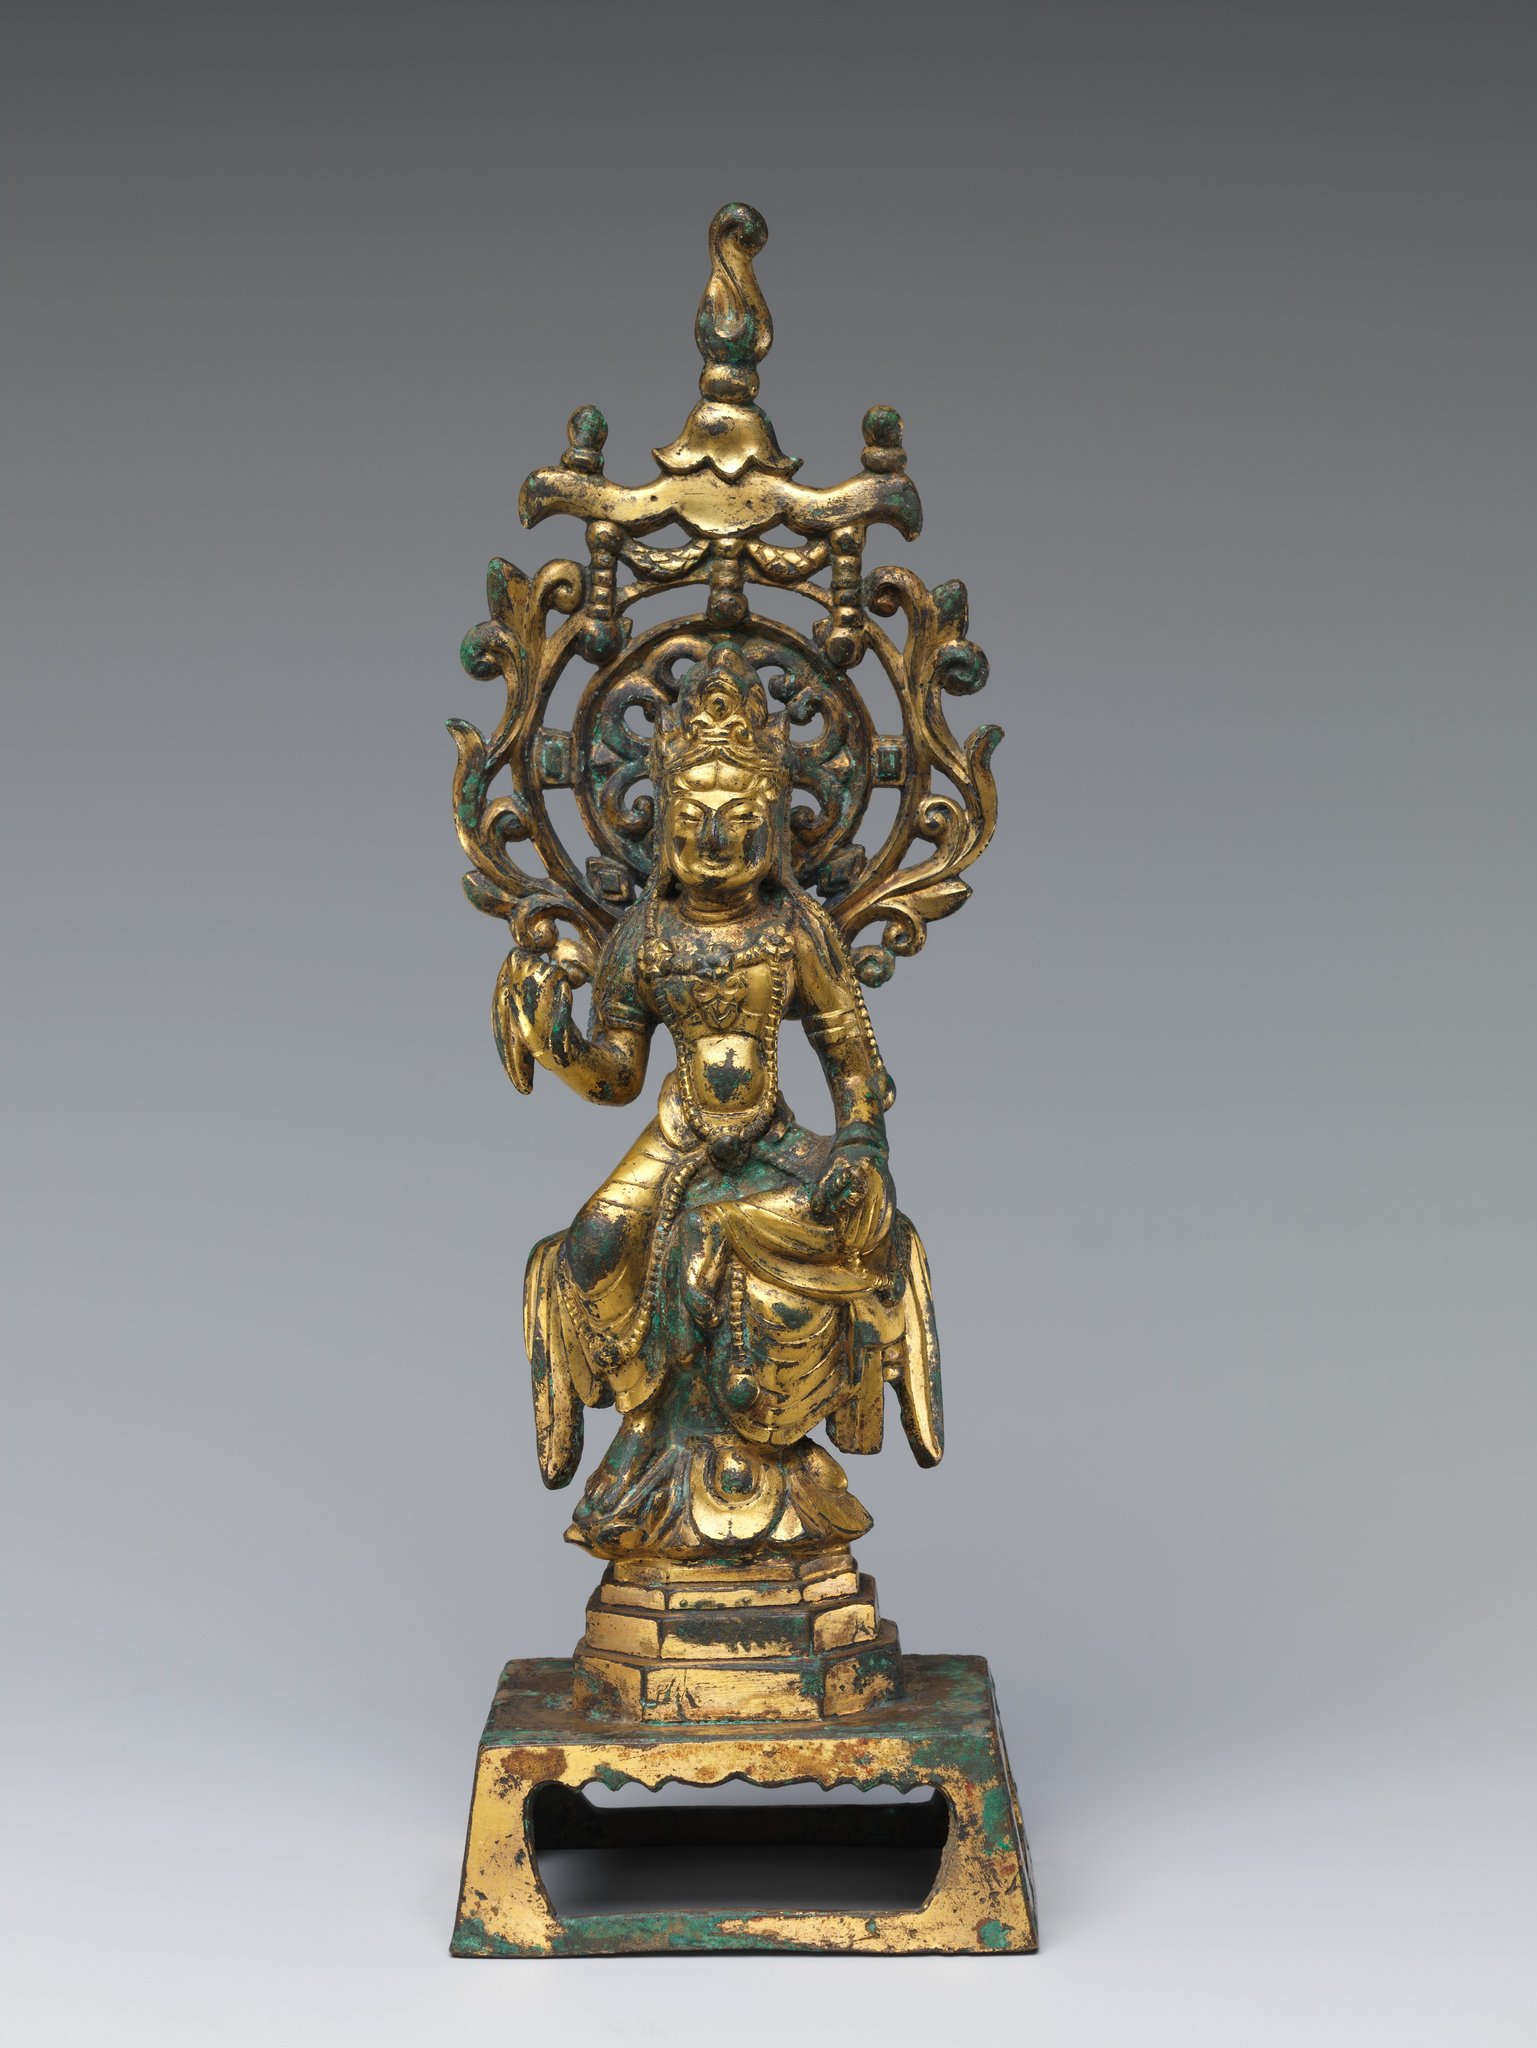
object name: figure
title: Bodhisattva Avalokiteshvara (Guanyin)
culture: chinese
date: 907-960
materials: gilt bronze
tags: buddhism,avalokiteshvara,bodhisattvas